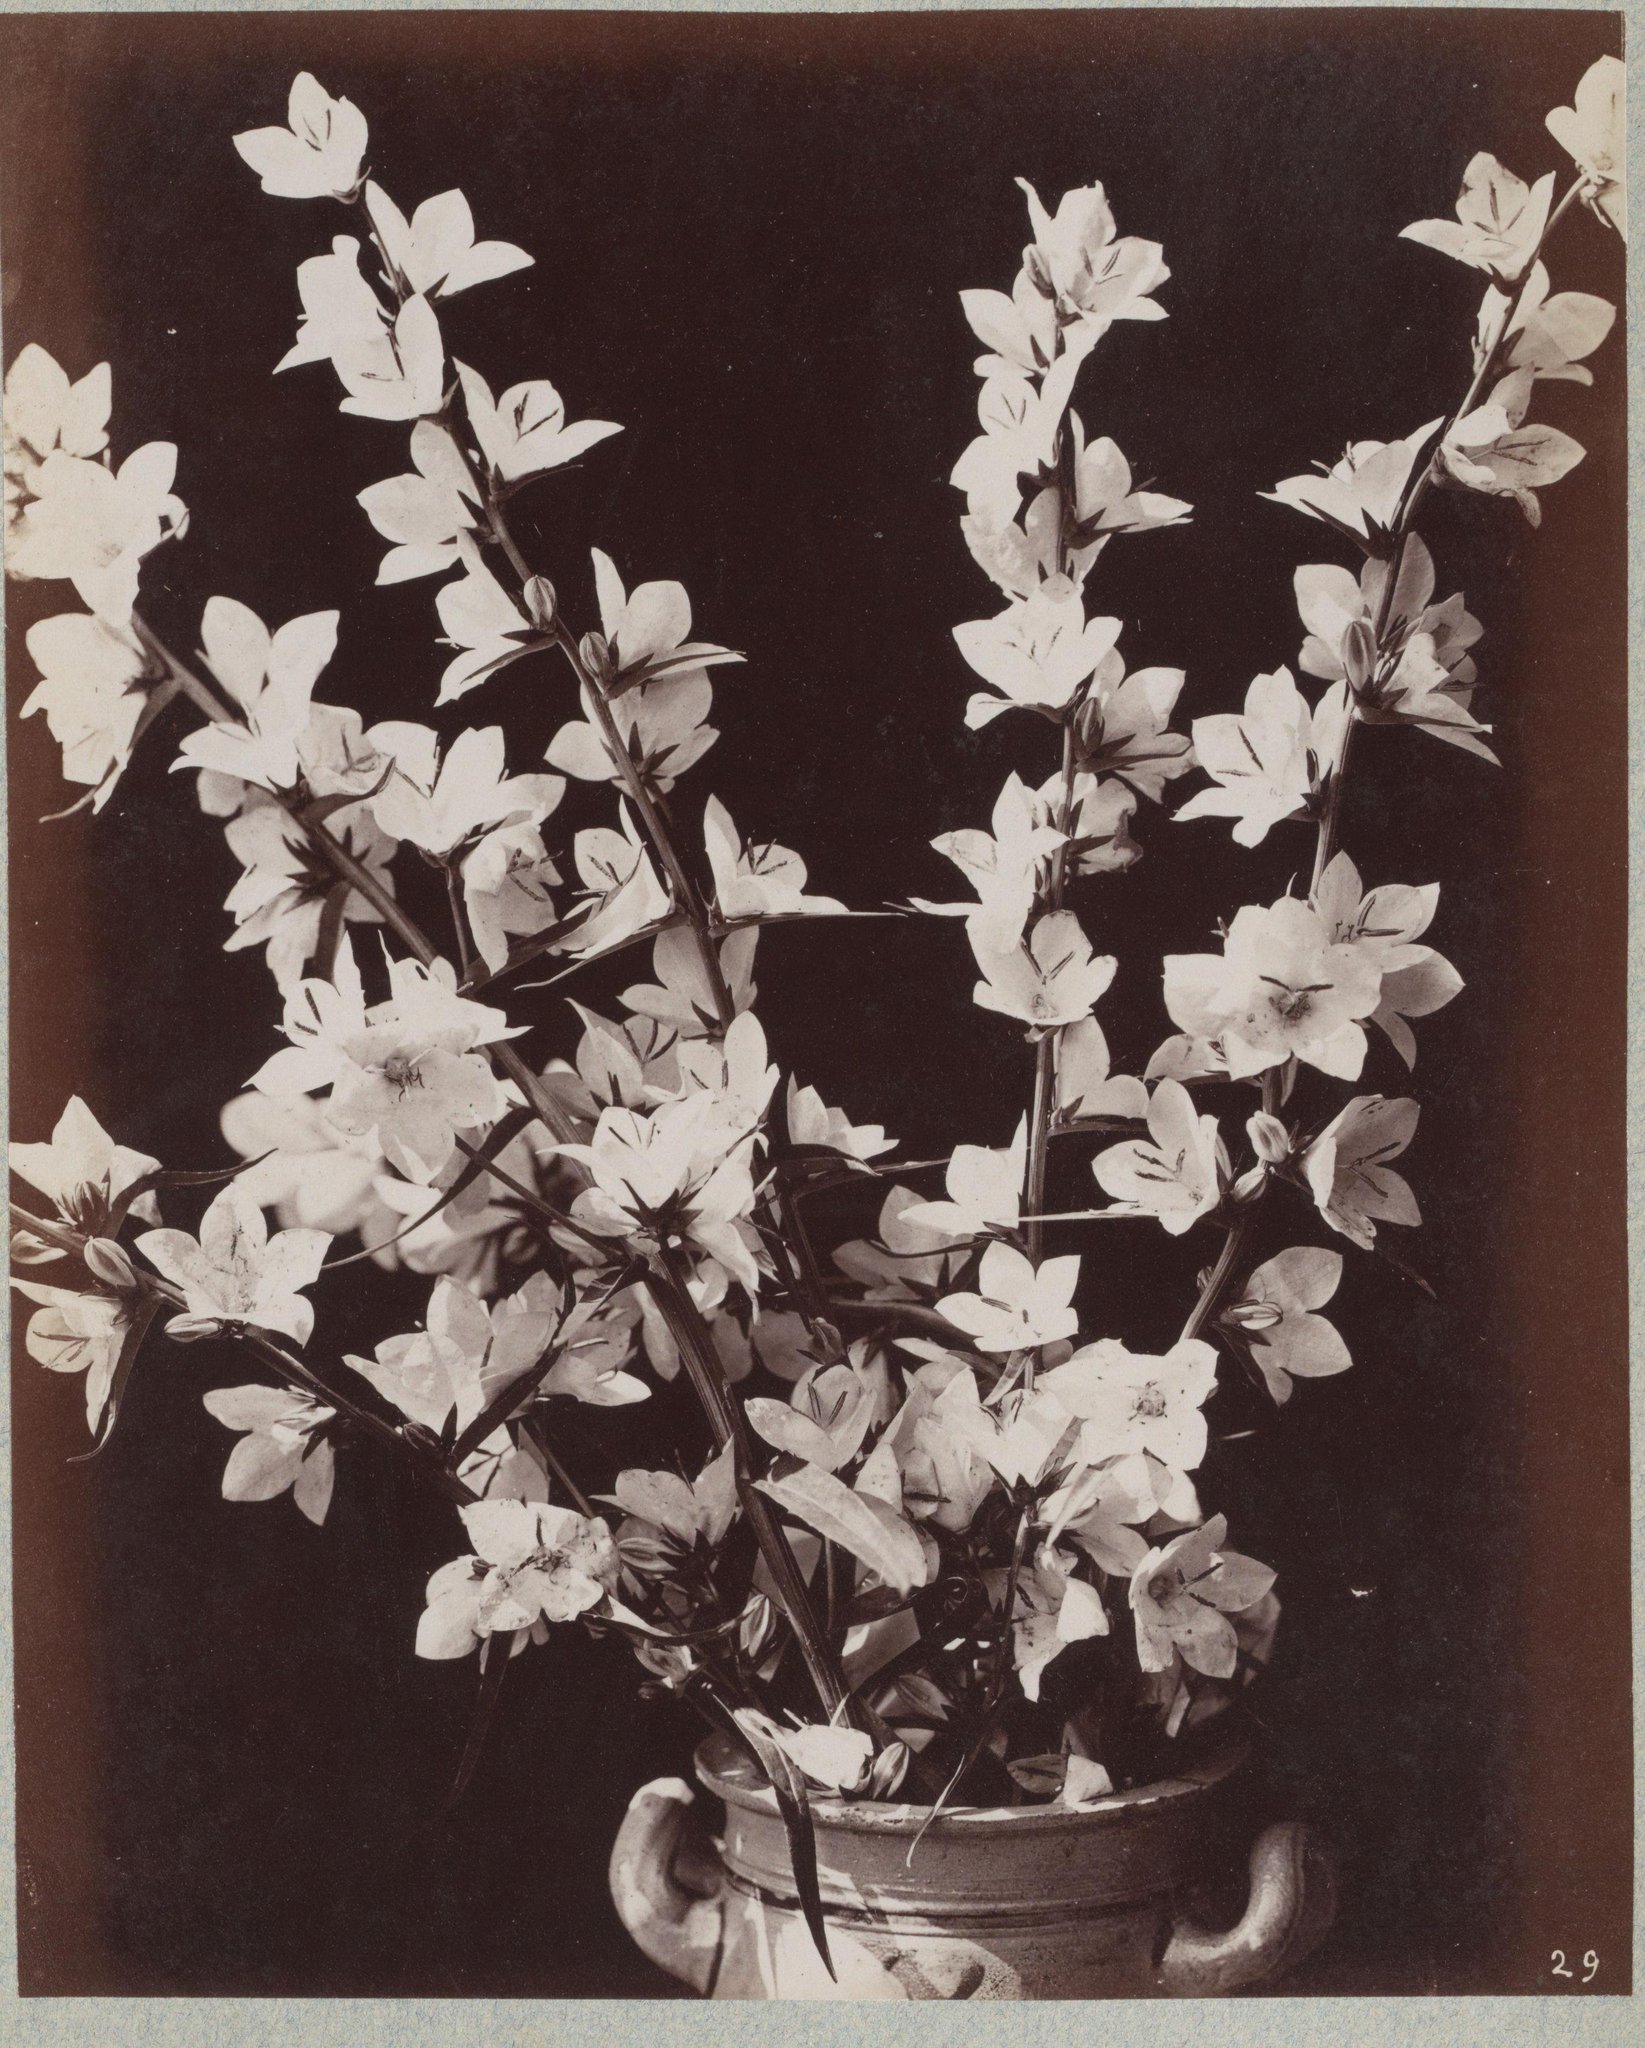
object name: photograph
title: Bloemstudie met Keulse pot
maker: a. calavas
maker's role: publisher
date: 1875-1895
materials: cardboard, photographic support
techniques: albumen print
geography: paris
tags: flowers, container of ceramics: jar, jug, pot, vase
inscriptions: number: ‘29’, collector's mark: Lugt 3937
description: Onderdeel van Verzamelband met foto's van bloemstudies.